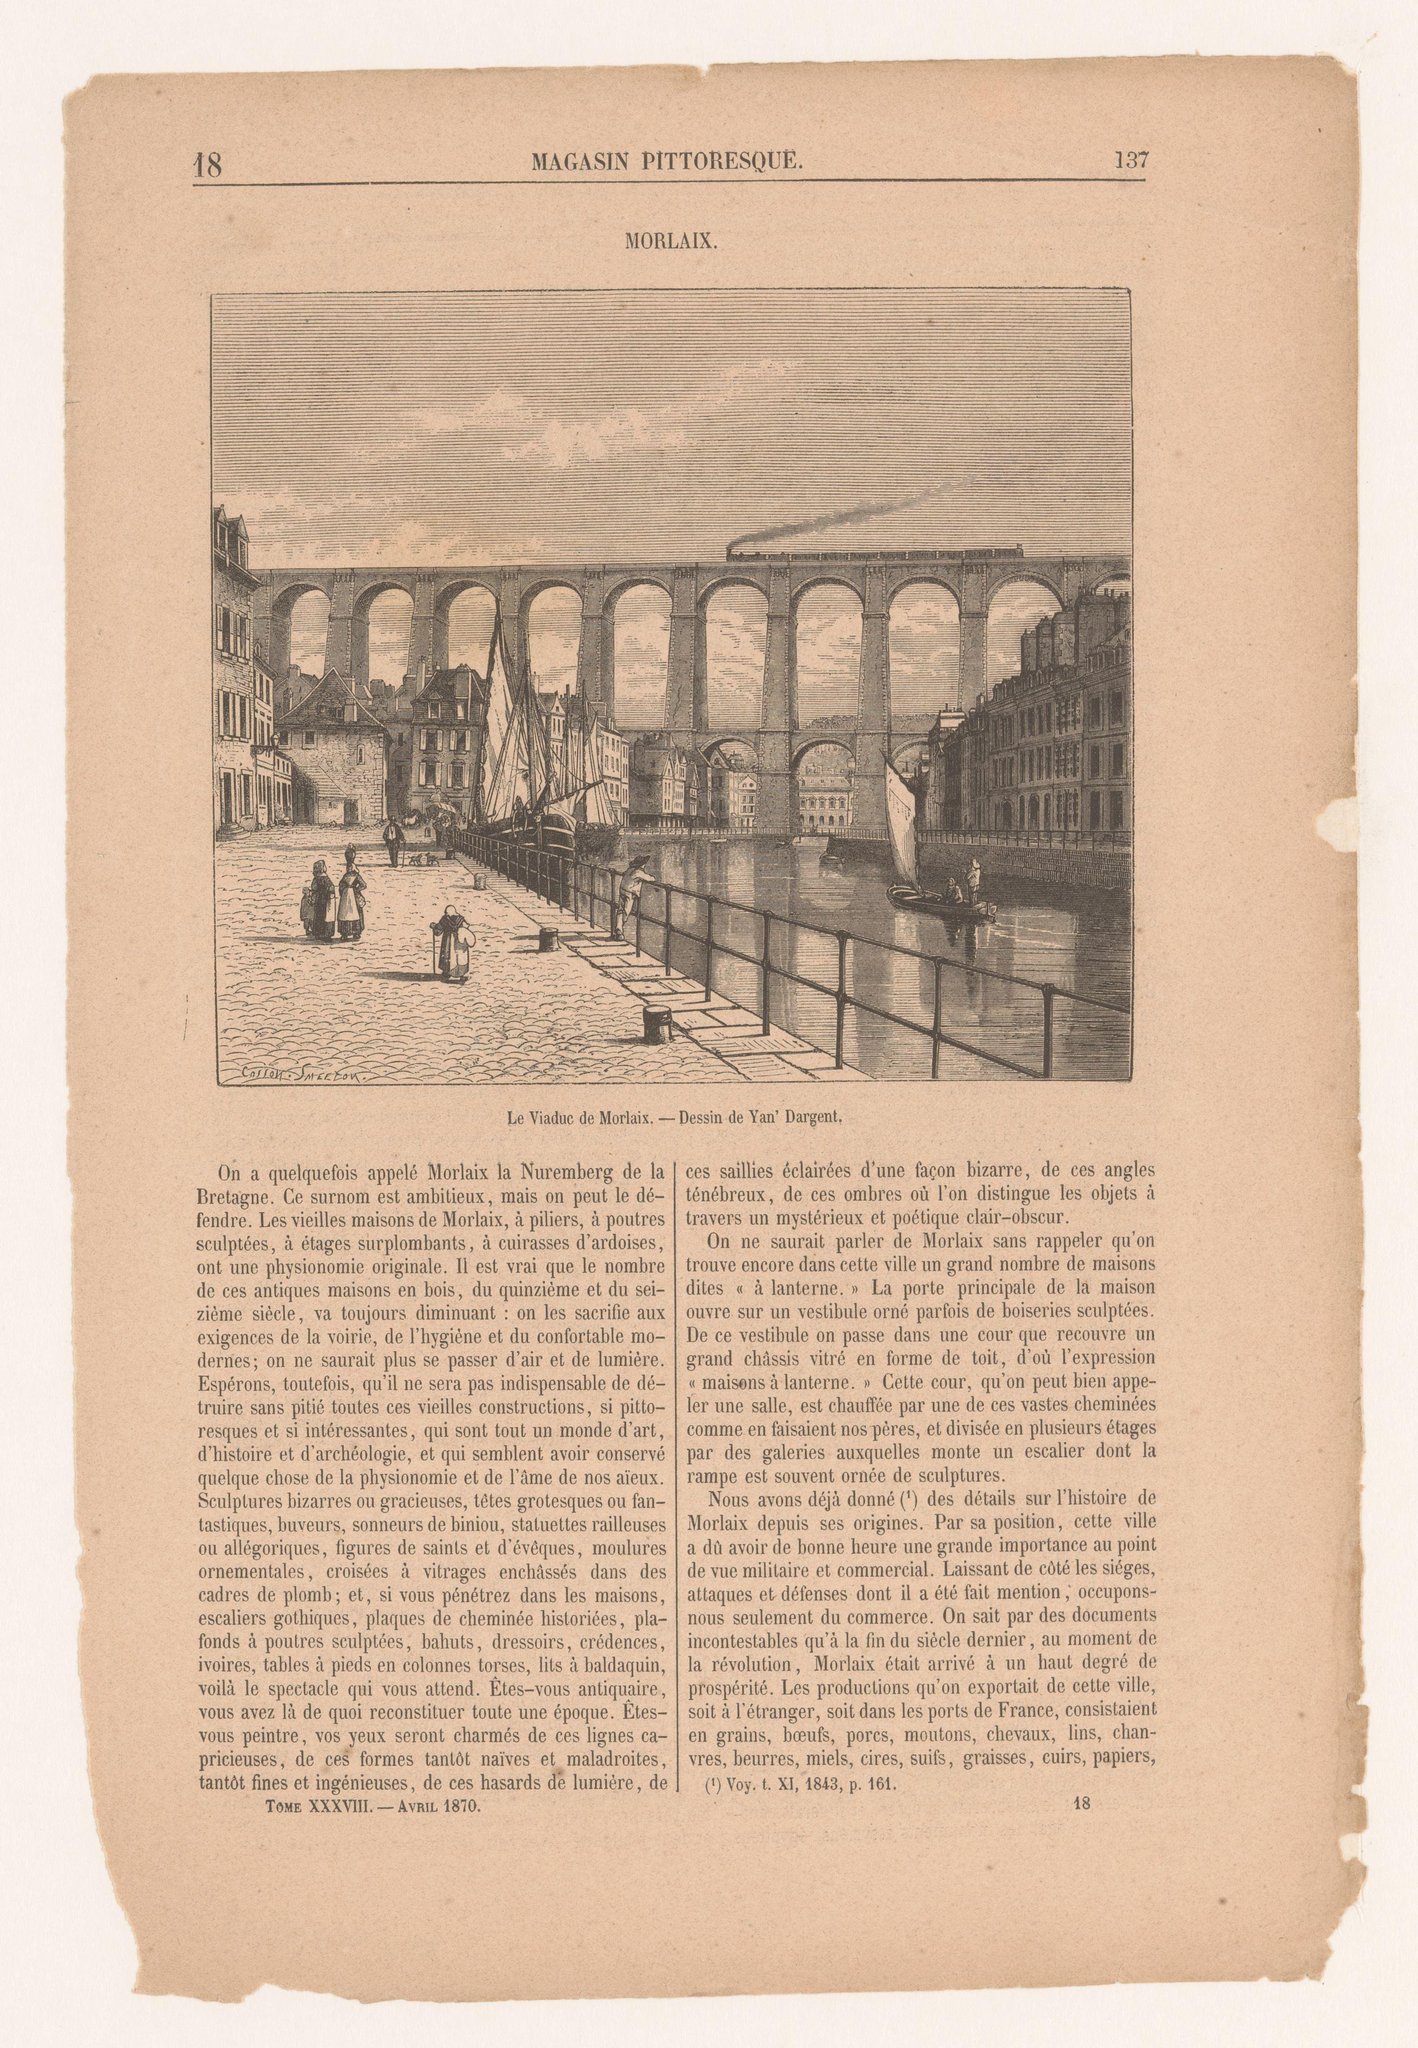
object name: book illustration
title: Le Viaduc de Morlaix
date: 1870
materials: paper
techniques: letterpress printing, engraving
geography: paris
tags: viaduct, city-view in general; 'veduta', canals, waters (in city)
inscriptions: collector's mark: Lugt 2228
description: Prent uit: Le Magasin Pittoresque, vol. 38, april 1870.